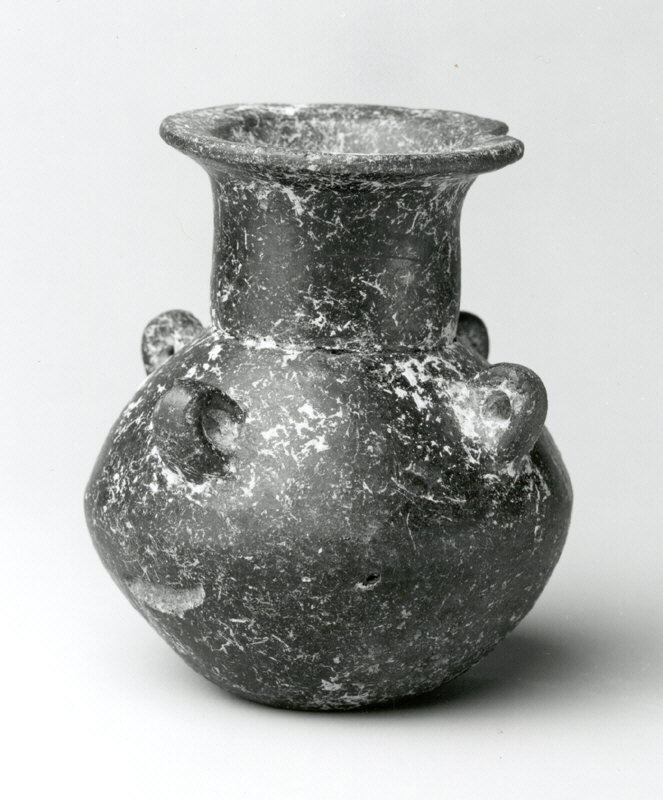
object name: vessel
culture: yortan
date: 2700-2400 BCE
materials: ceramic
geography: northwestern anatolia